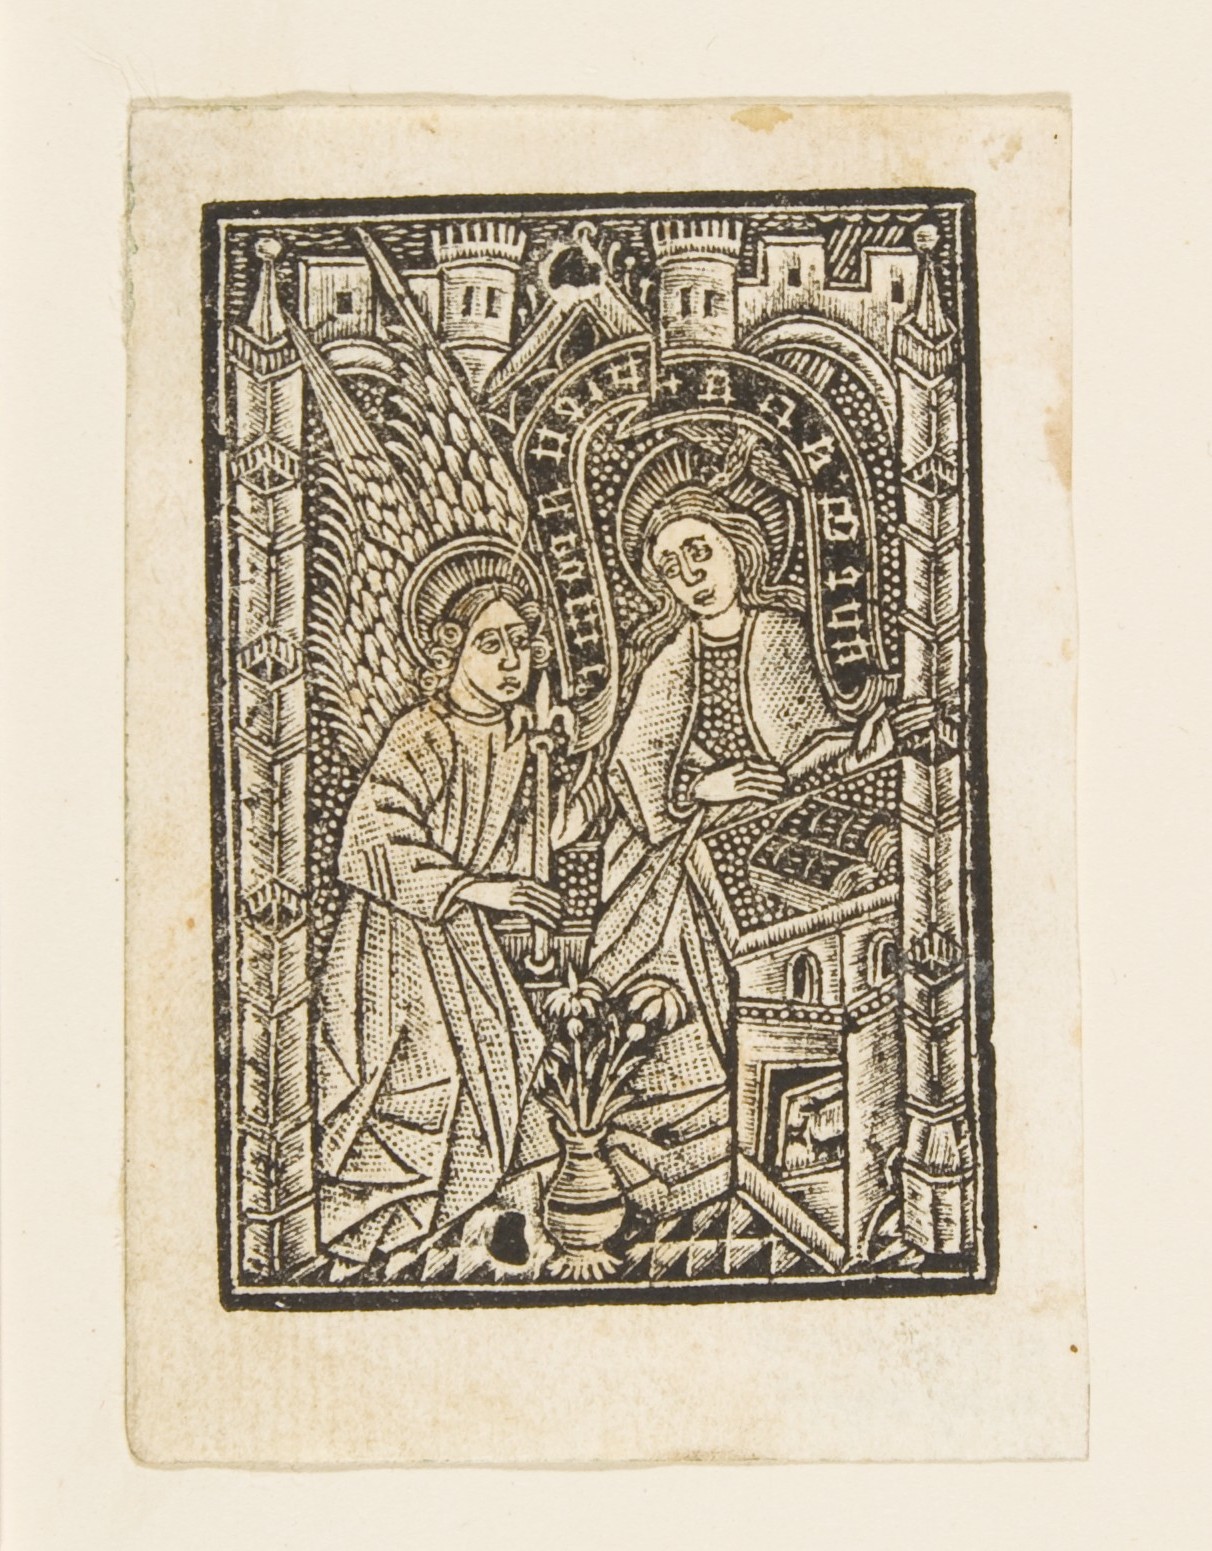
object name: print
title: The Annunciation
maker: anonymous, german, 15th century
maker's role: artist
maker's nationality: german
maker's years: 1400-1500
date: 1401-1500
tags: annunciation